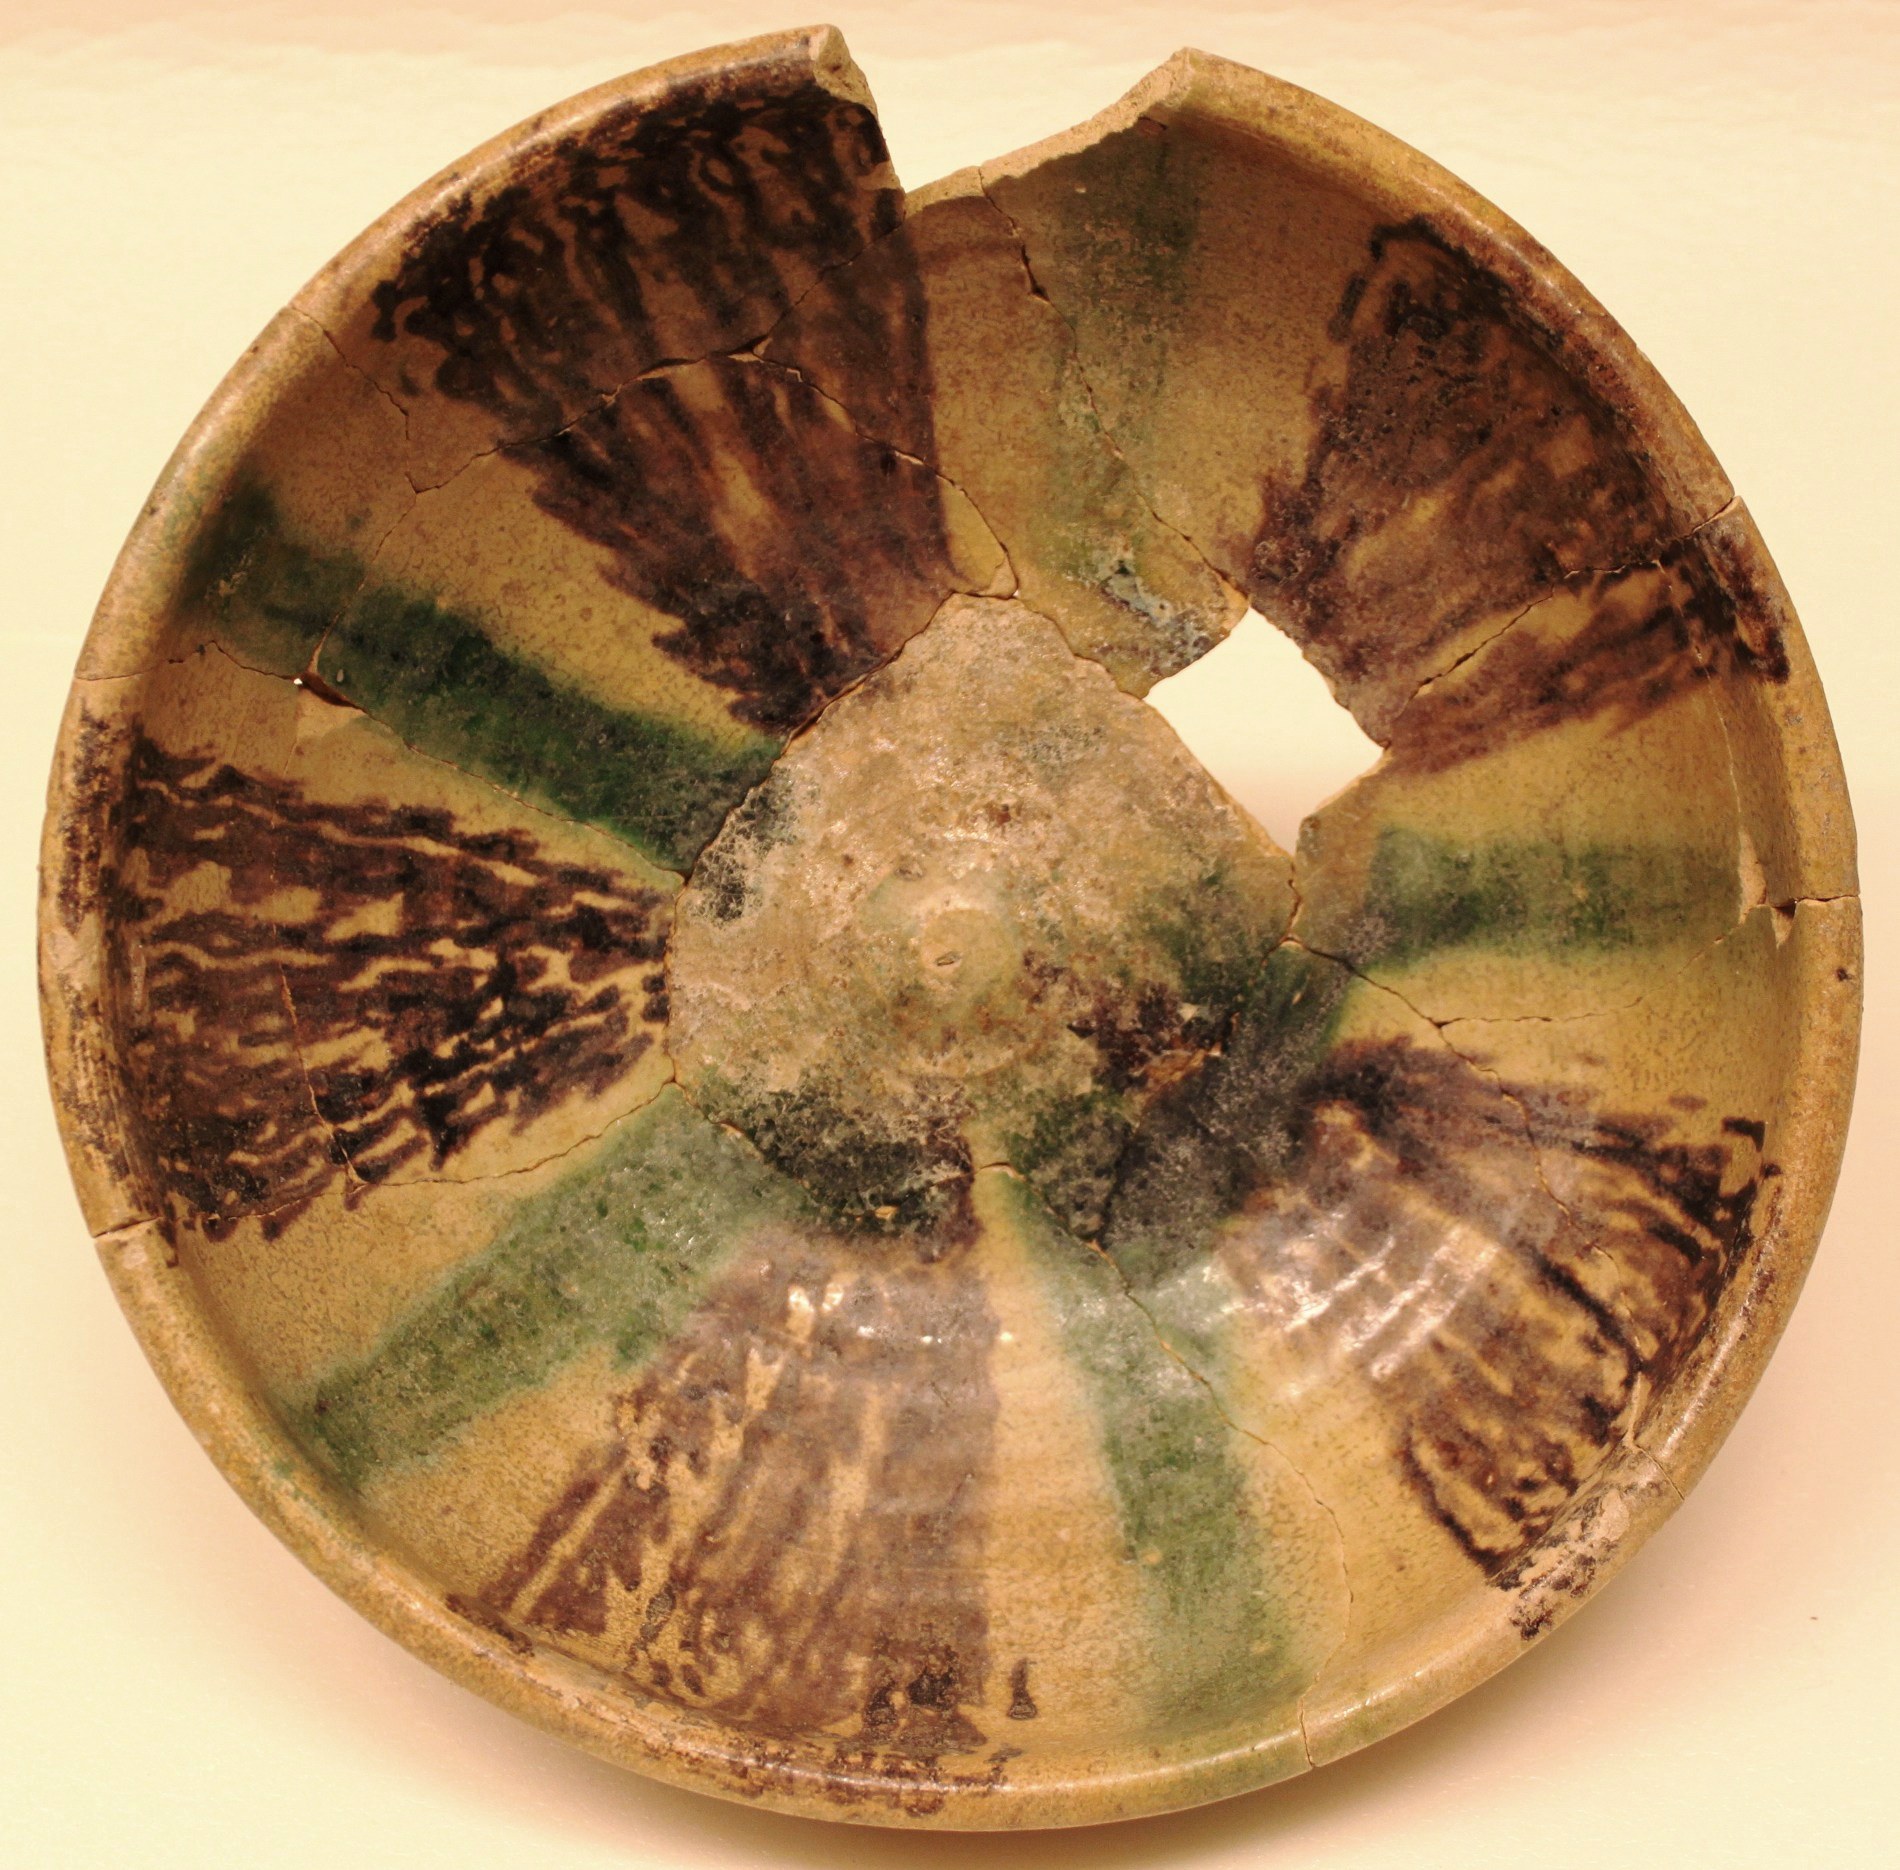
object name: bowl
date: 701-900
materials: earthenware, glaze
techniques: polychrome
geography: iran